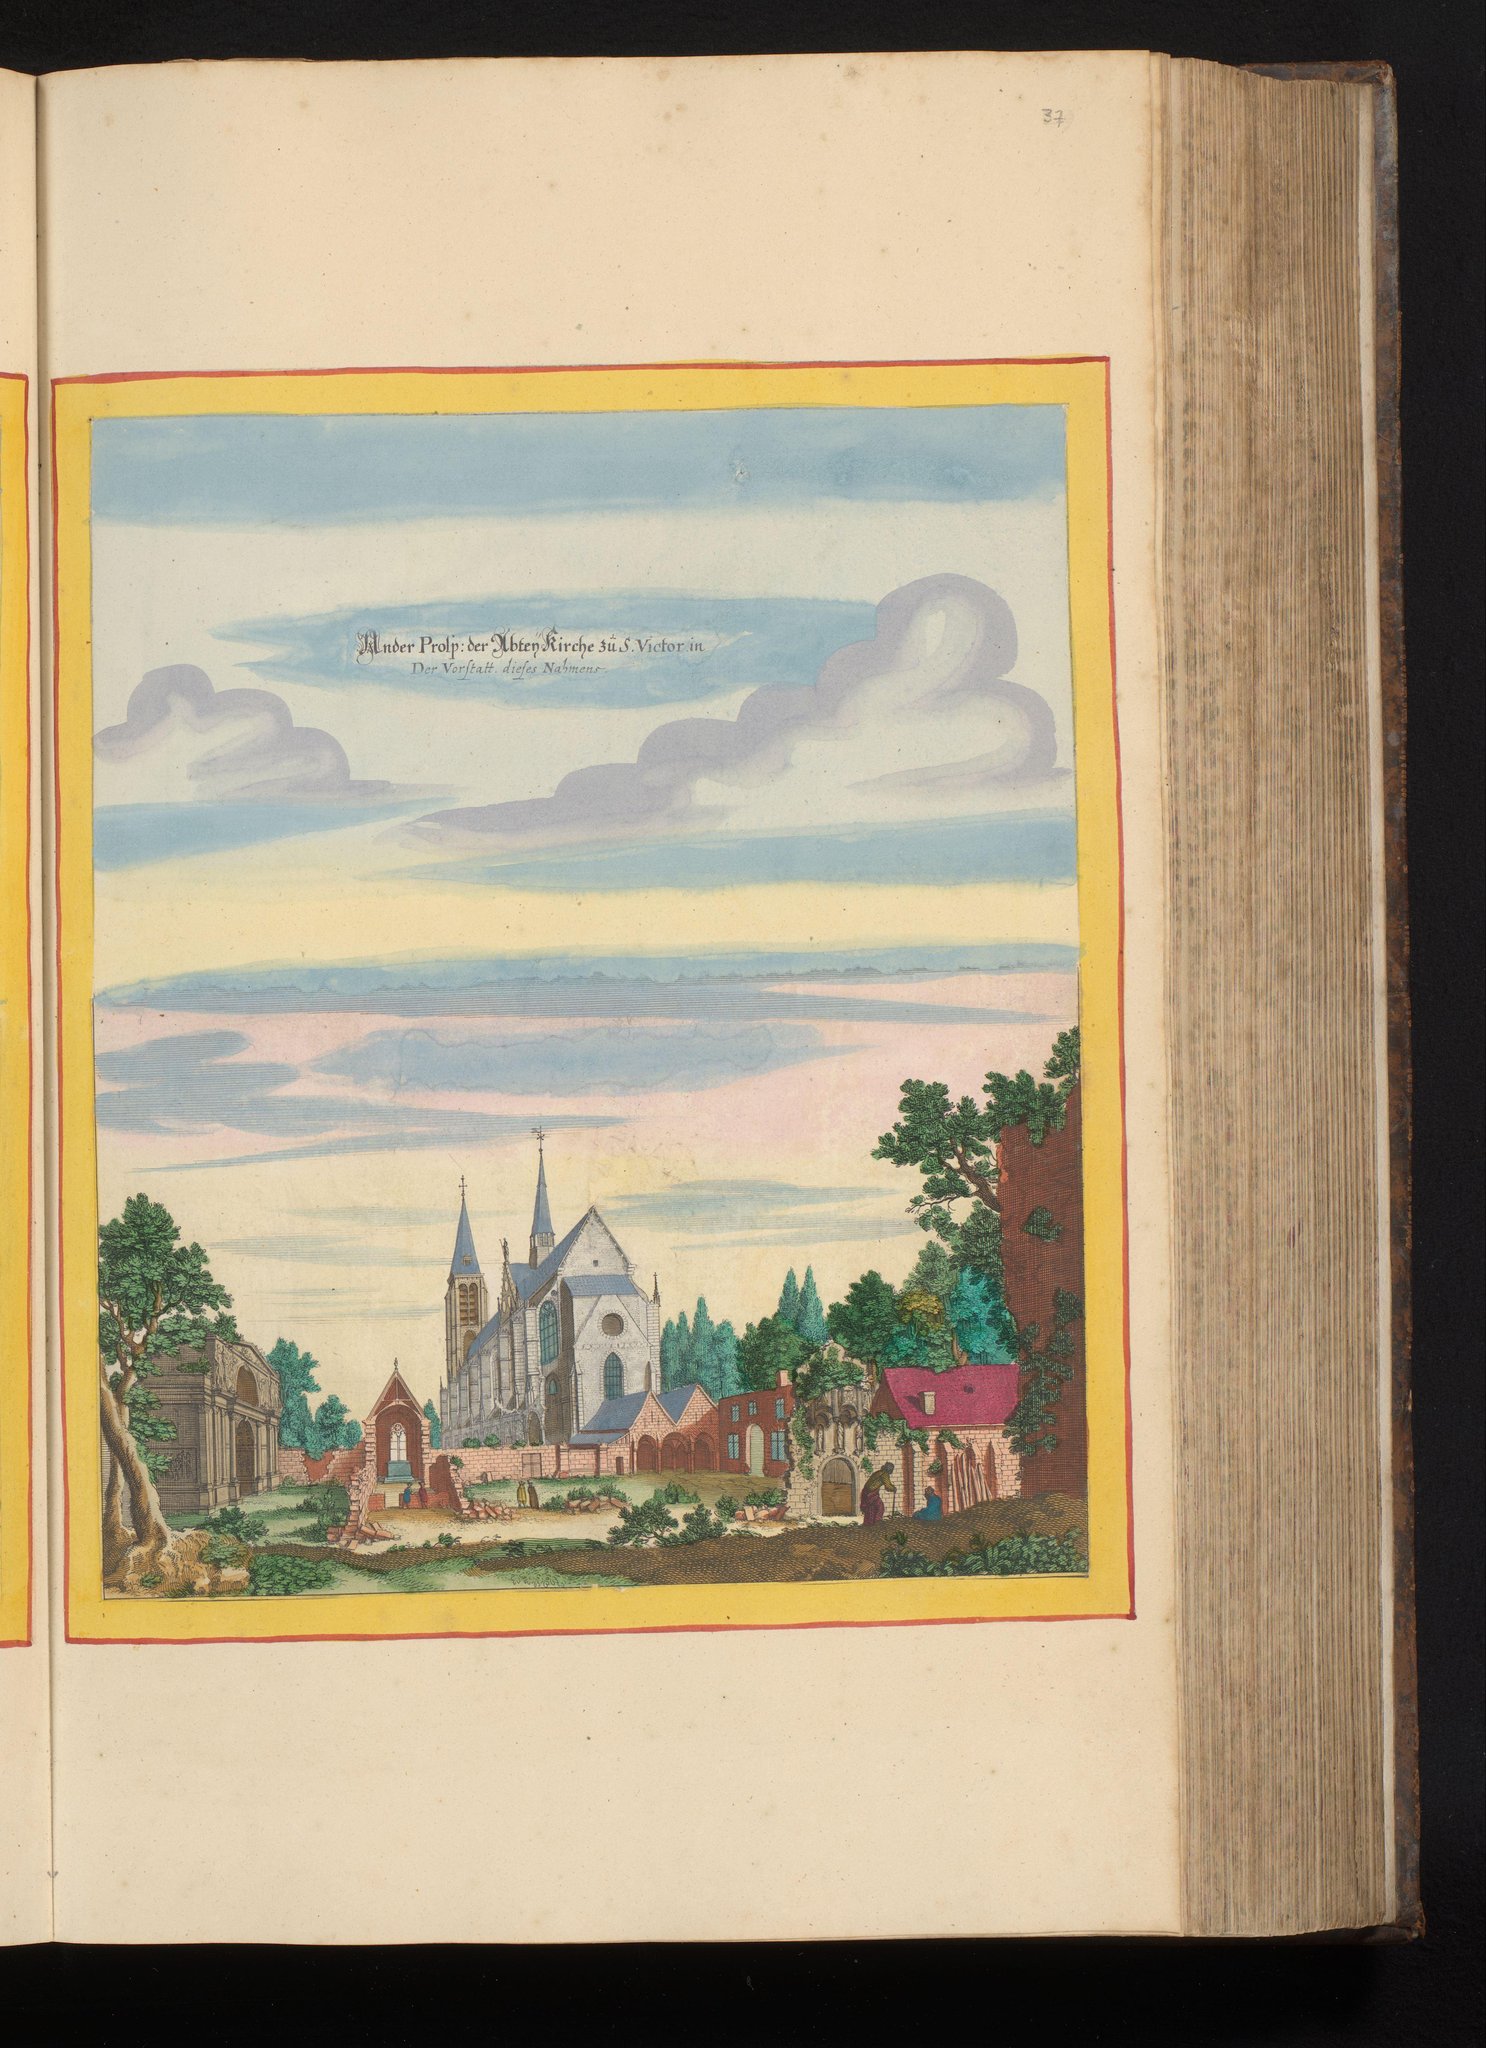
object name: album leaf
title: Ander Prosp. der Abten Kirche zu St. Victor in der Vorstatt dieses Nahmens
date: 1655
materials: paper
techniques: engraving, etching, hand coloring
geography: the hague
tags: church (exterior)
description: Prent origineel vervaardigd als boekillustratie voor: Zeiller, Martin. Topographia Galliae, oder Beschreibung und Contrafaitung der vornehmbsten und bekantisten Oerter in dem mächtigen und grossen Königreich Frankreich, 13 delen. Frankfurt am Main: Caspar Merian, 1655-1661. De prent werd voor het eerst gepubliceerd in deel 1: Topographia Galliae, 1655.